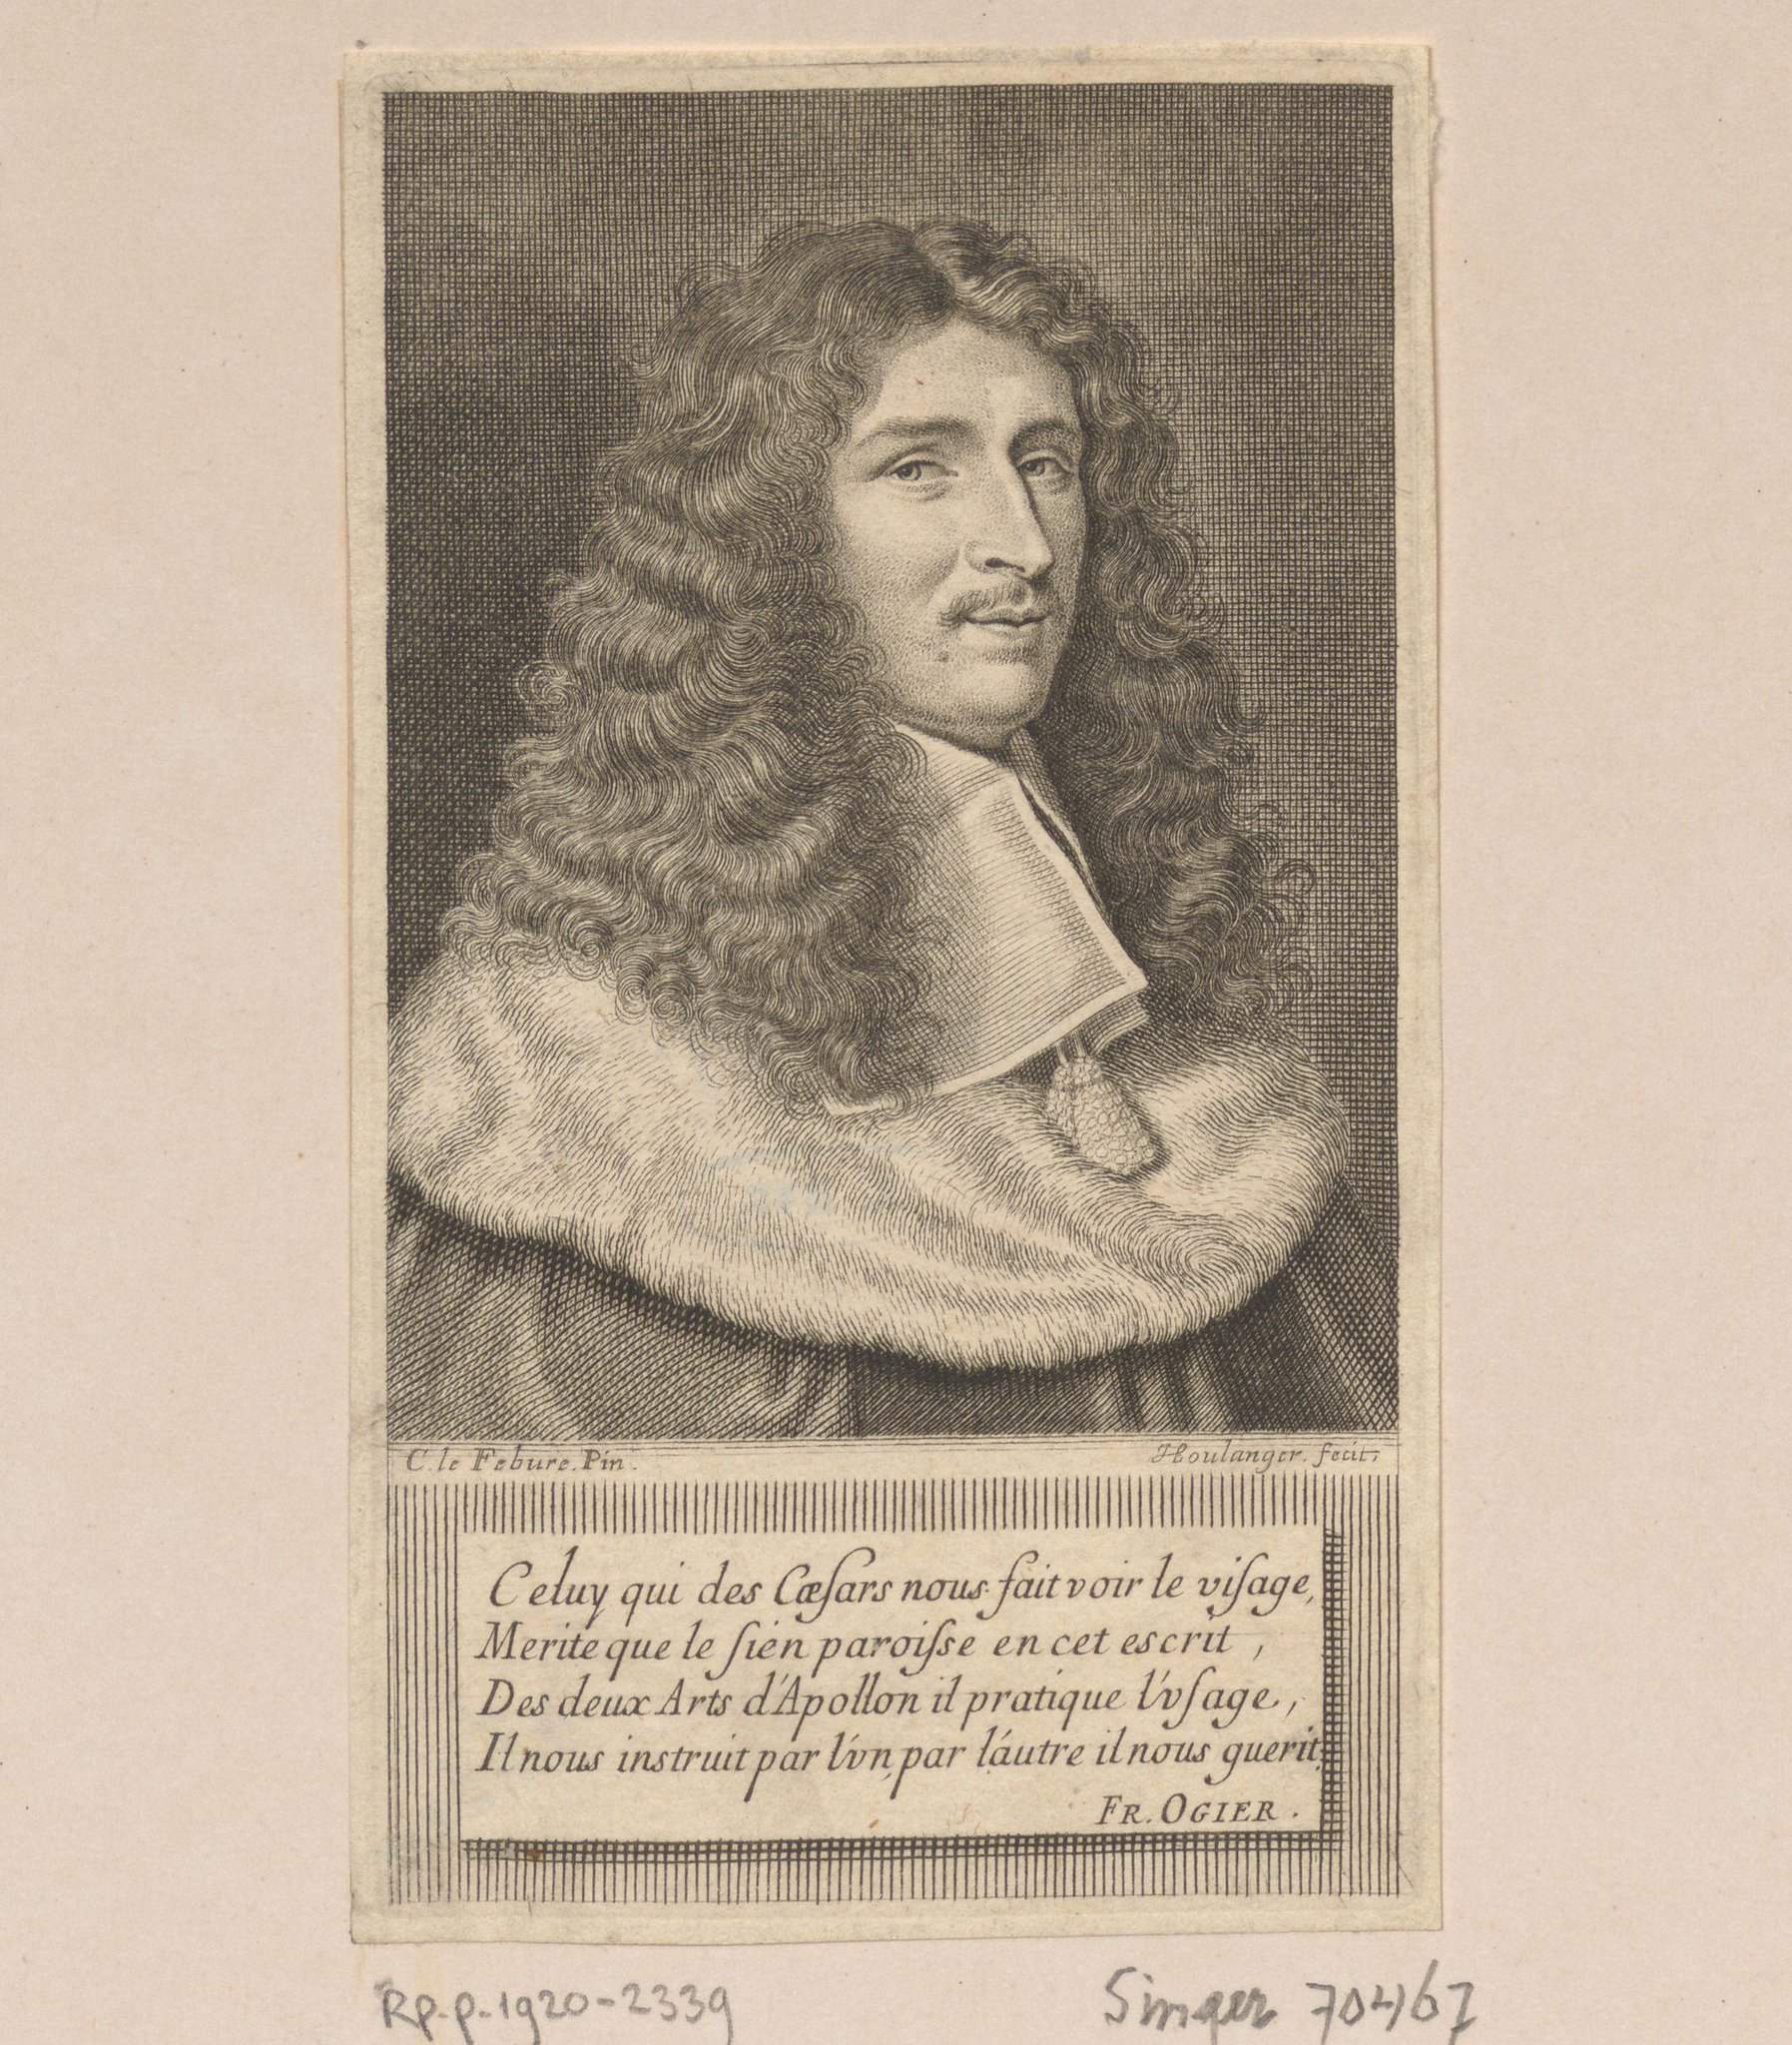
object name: print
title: Portret van Charles Patin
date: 1667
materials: paper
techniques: engraving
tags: charles patin, historical persons, physician, doctor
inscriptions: collector's mark: Lugt 2228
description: Prent mogelijk uit: Patin, Charles. Introduction a la connoissance des medailles. Parijs: Jean du Bray, 1667.